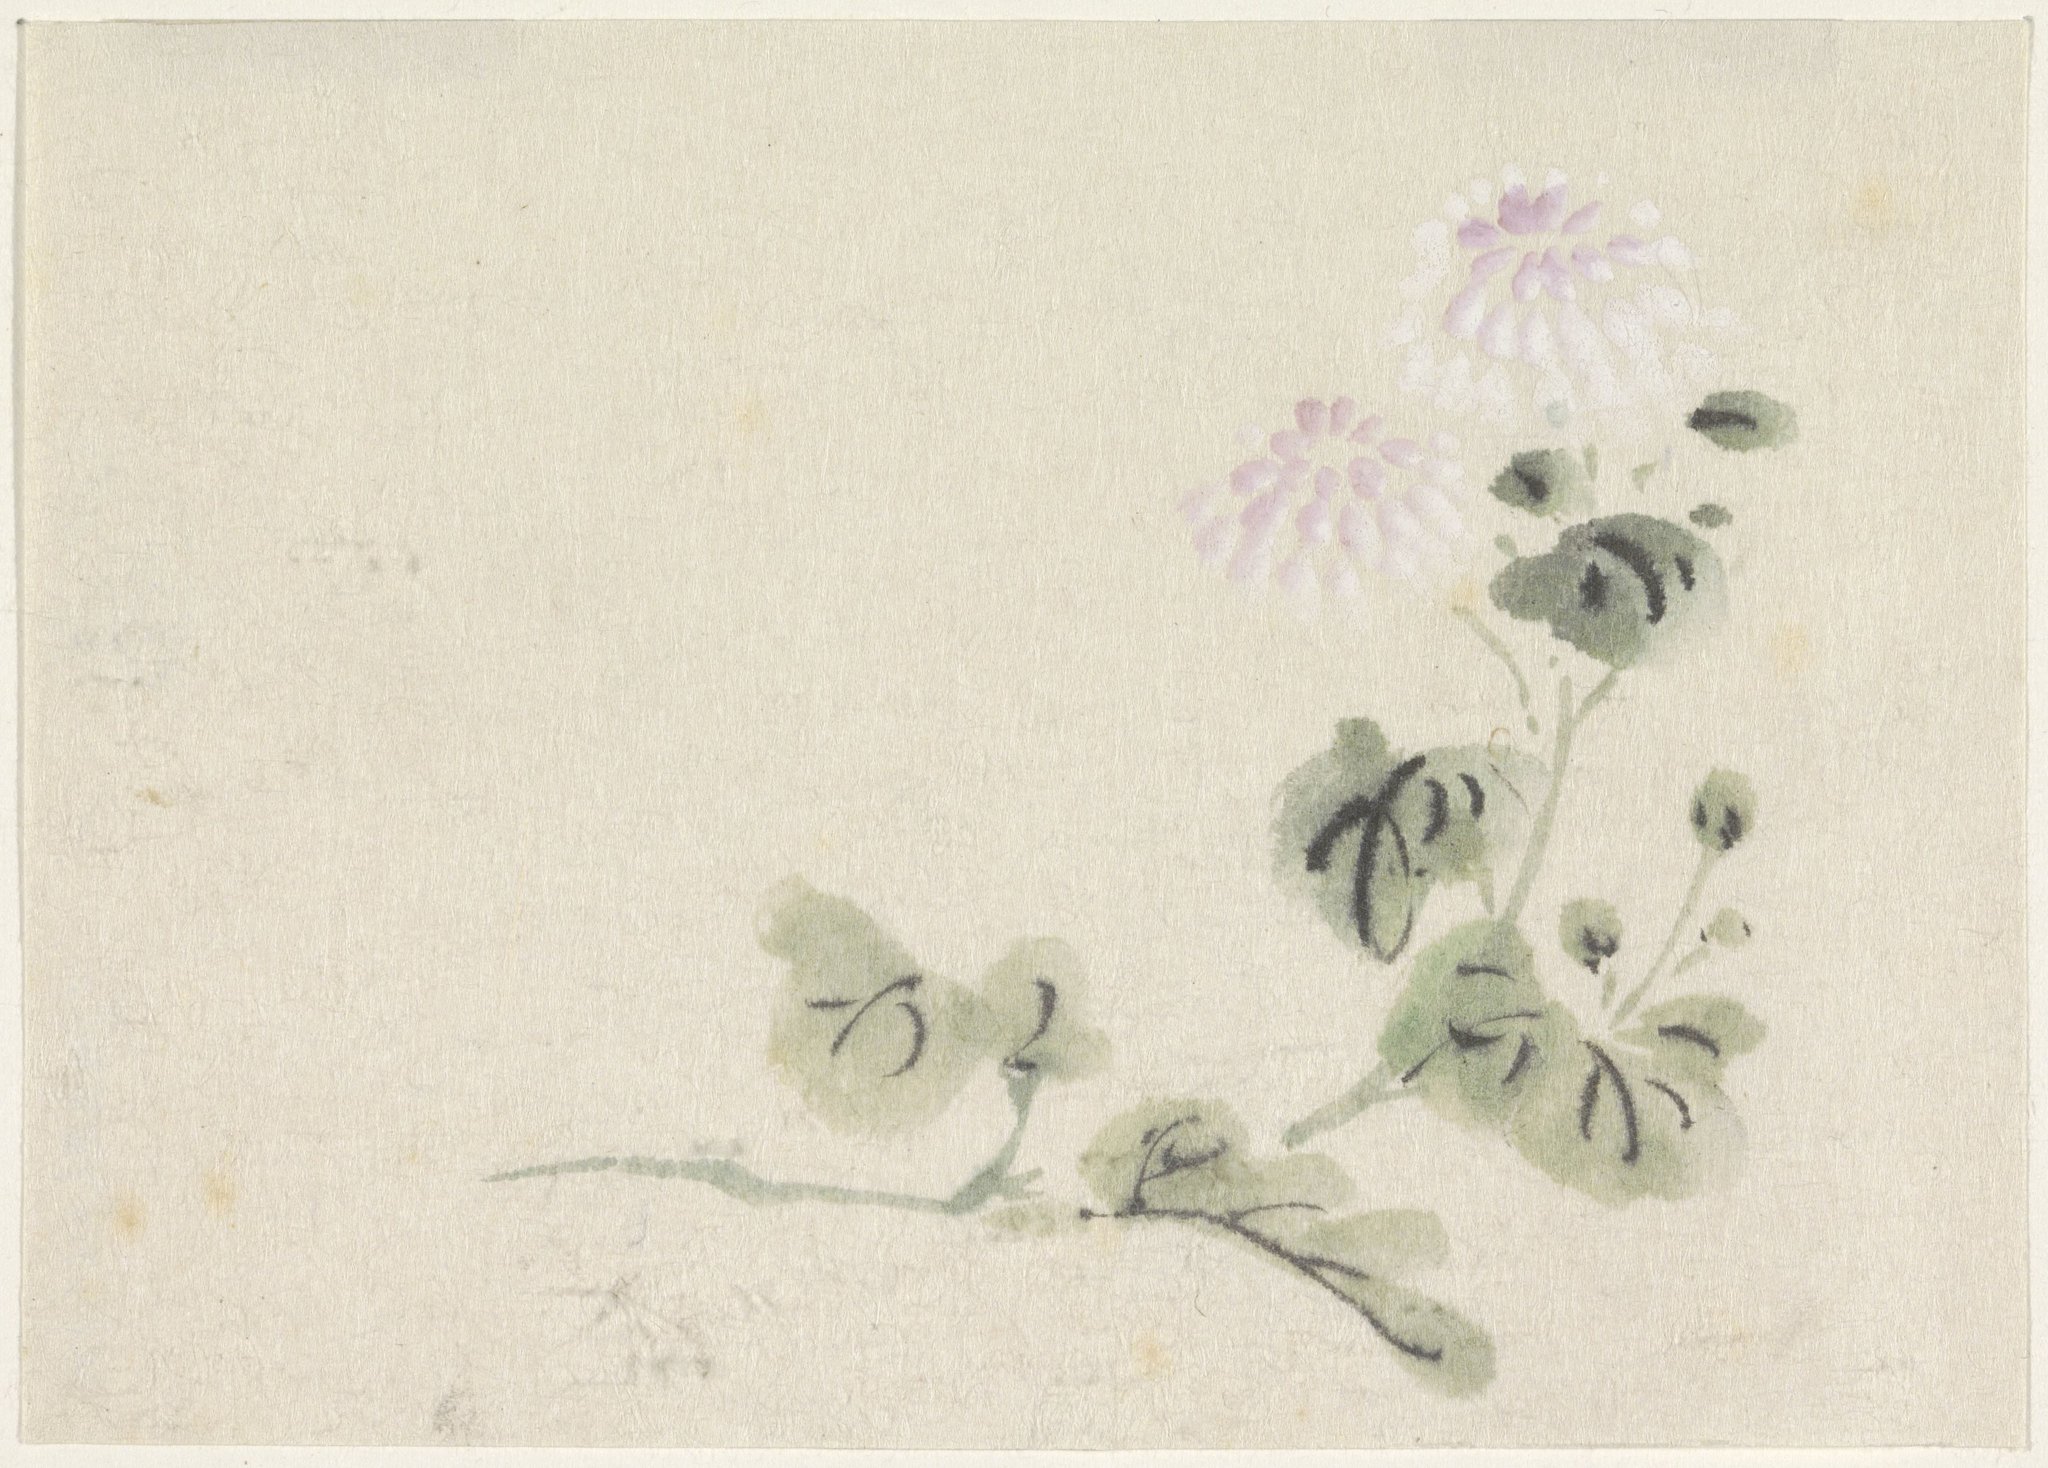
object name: watercolor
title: Paars-witte chrysanten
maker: utagawa kuniyoshi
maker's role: draughtsman, print maker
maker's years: 1798-1861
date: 1808-1861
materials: paint, paper, watercolor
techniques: brush